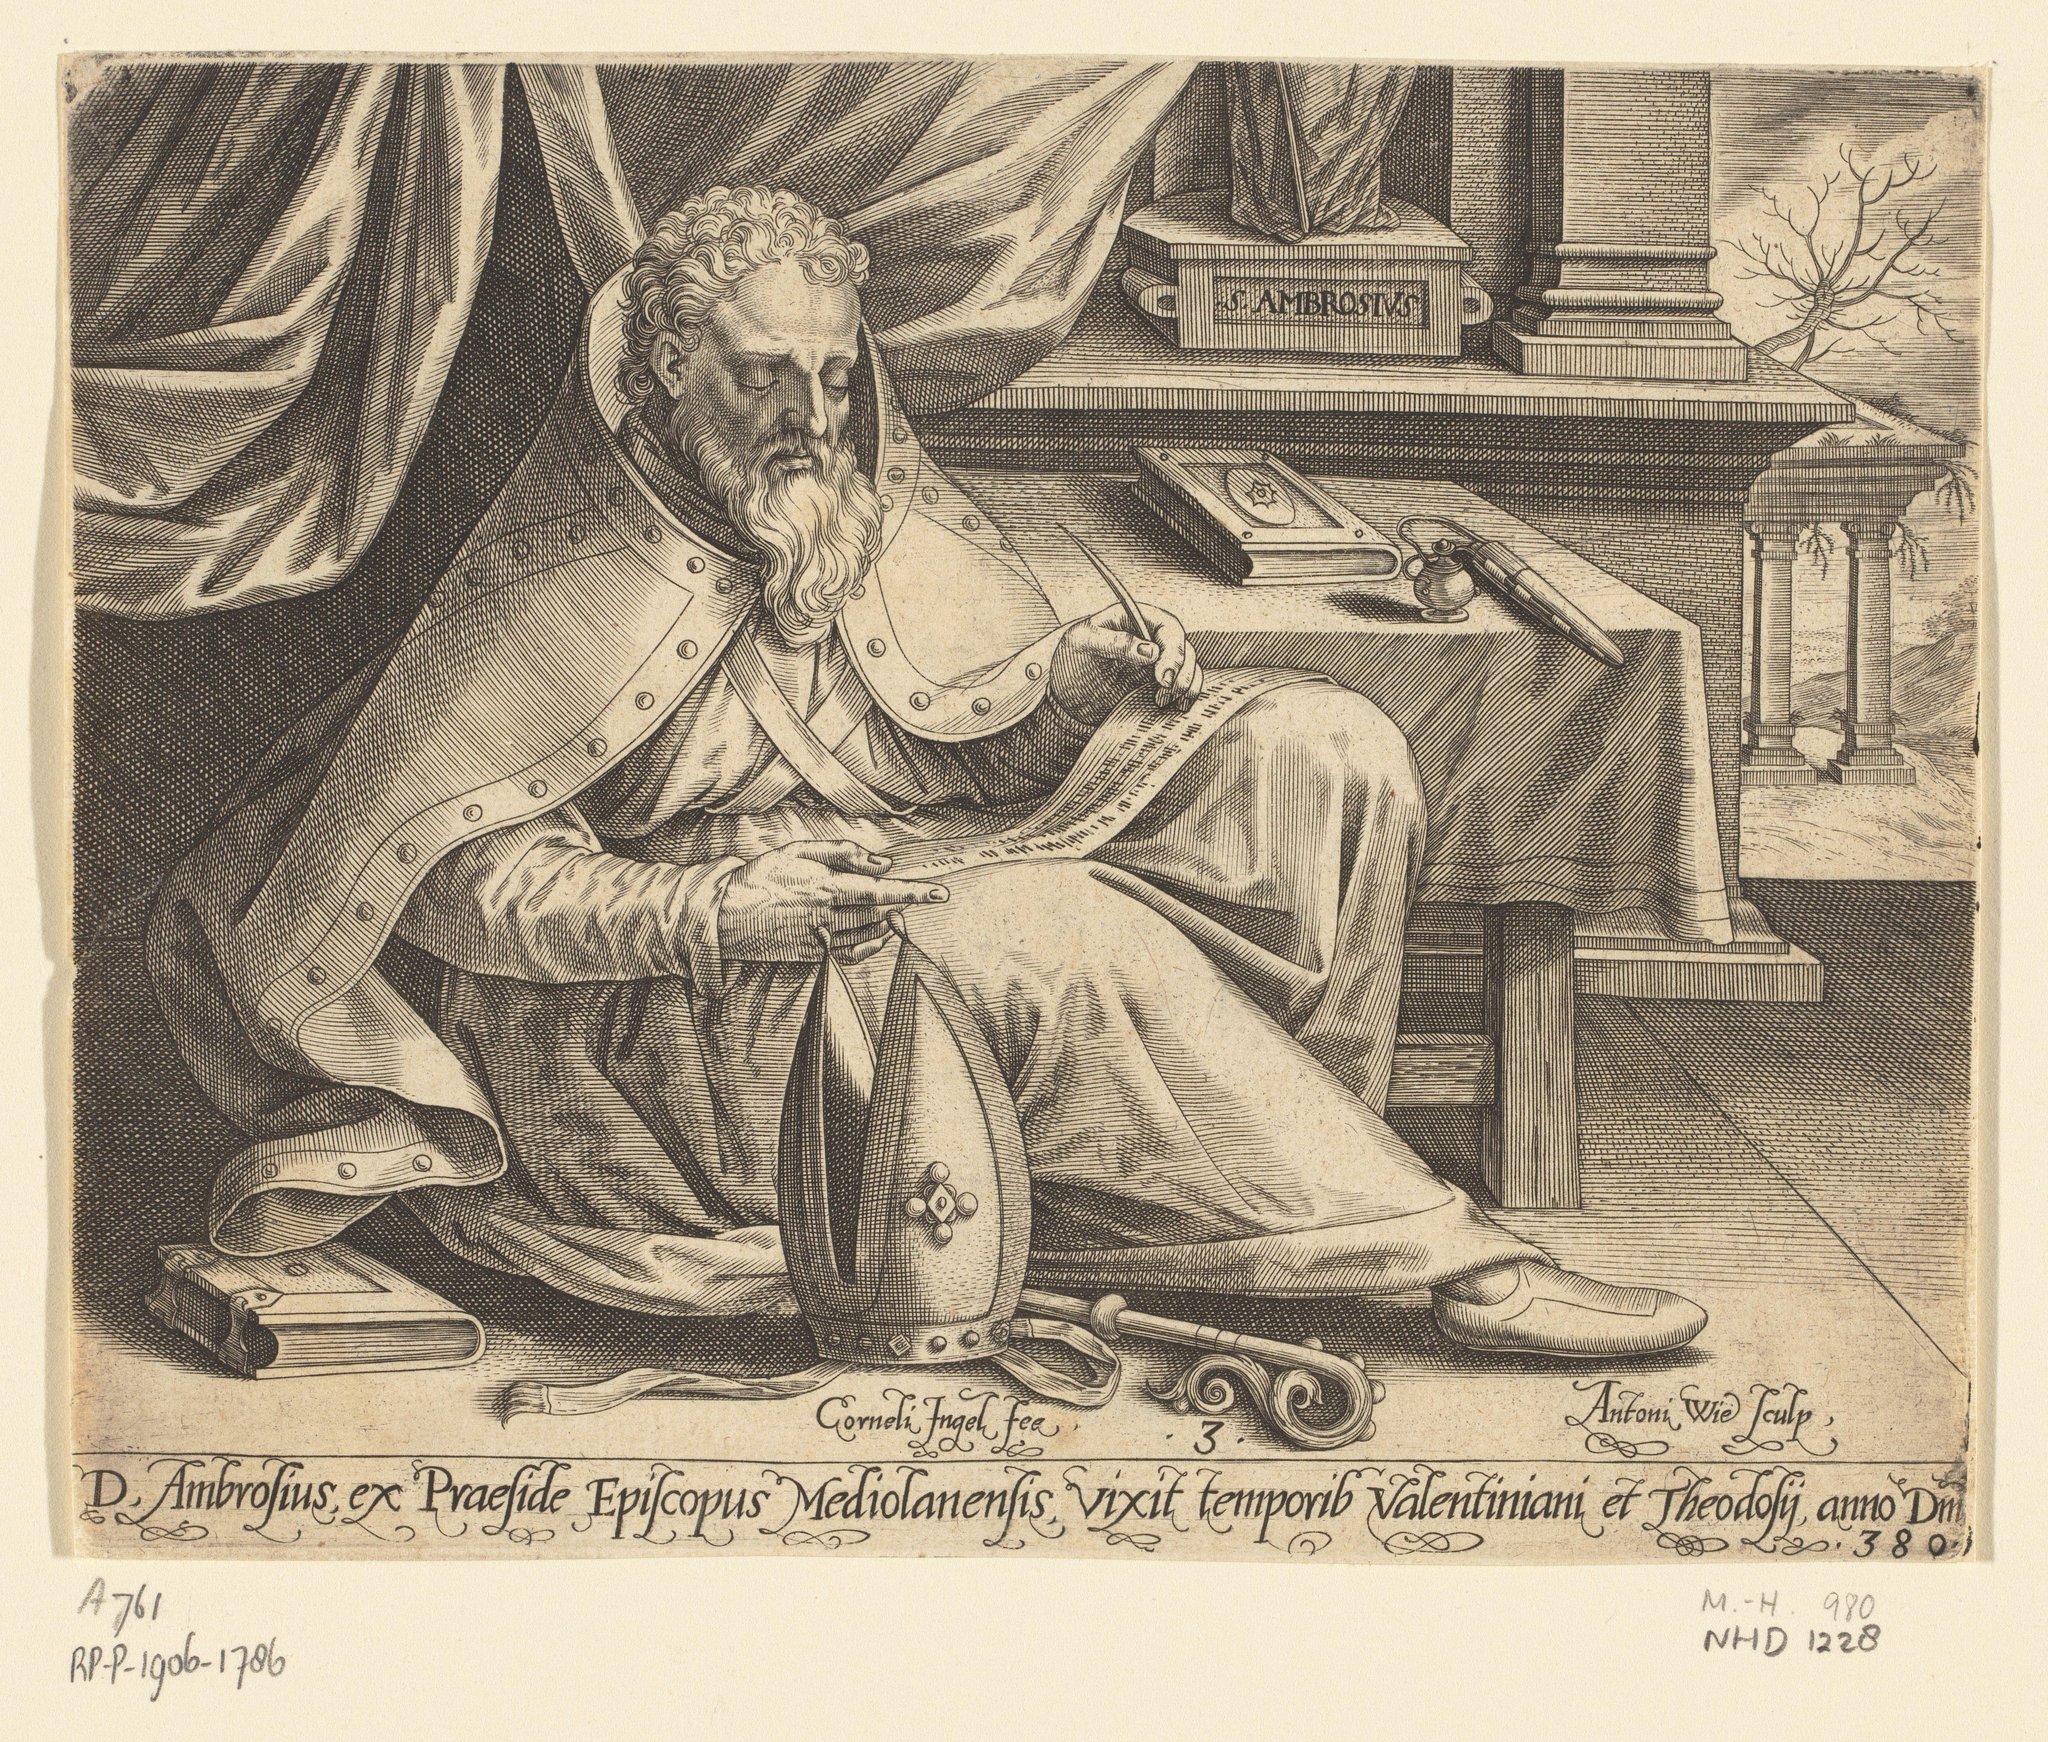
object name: print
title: De vier kerkvaders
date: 1586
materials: paper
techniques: engraving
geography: antwerp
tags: the four latin (western) fathers of the church together: ambrose (usually as bishop), jerome (usually as cardinal), augustine (usually as bishop), gregory the great (usually as pope), ambrose, bishop of milan; possible attributes: beehive, cradle with baby, three-knotted scourge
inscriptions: collector's mark: Lugt 2228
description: De H. Ambrosius schrijft op een rol papier. Hij draagt de bisschopsmantel. Aan zijn voeten zijn mijter en staf. In de marge een onderschrift in het Latijn.